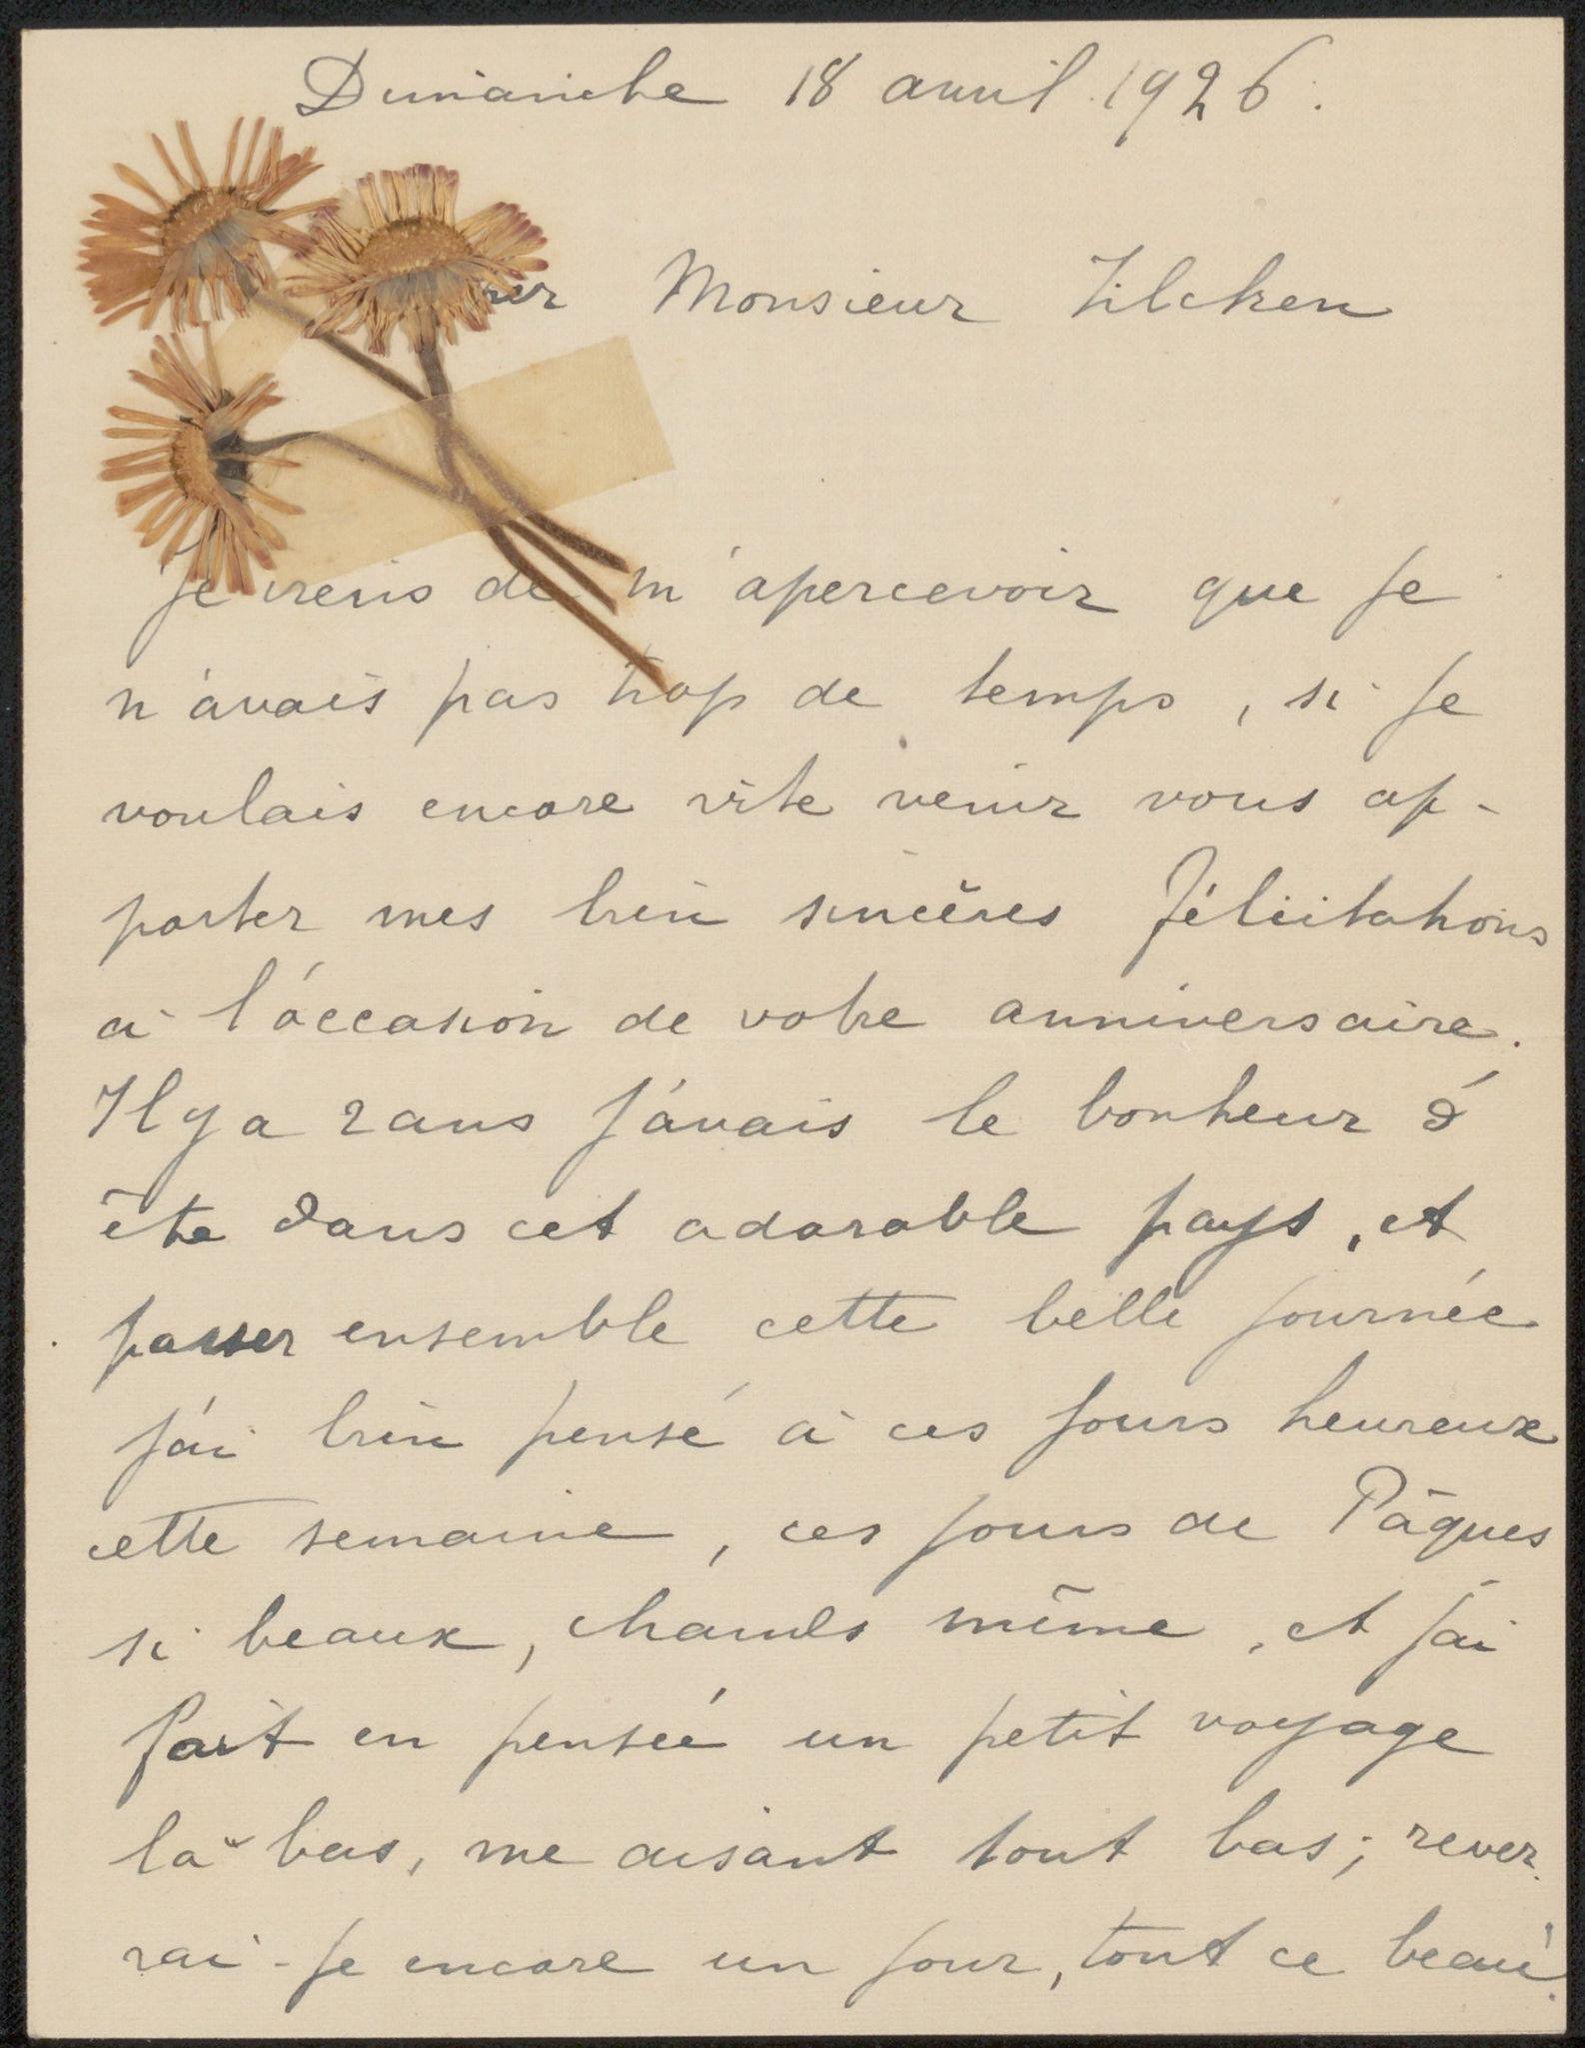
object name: letter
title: Brief aan Philip Zilcken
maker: Anonymous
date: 1926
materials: ink, paper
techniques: pen, writing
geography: the hague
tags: the hague, painter, draughtsman, philip zilcken